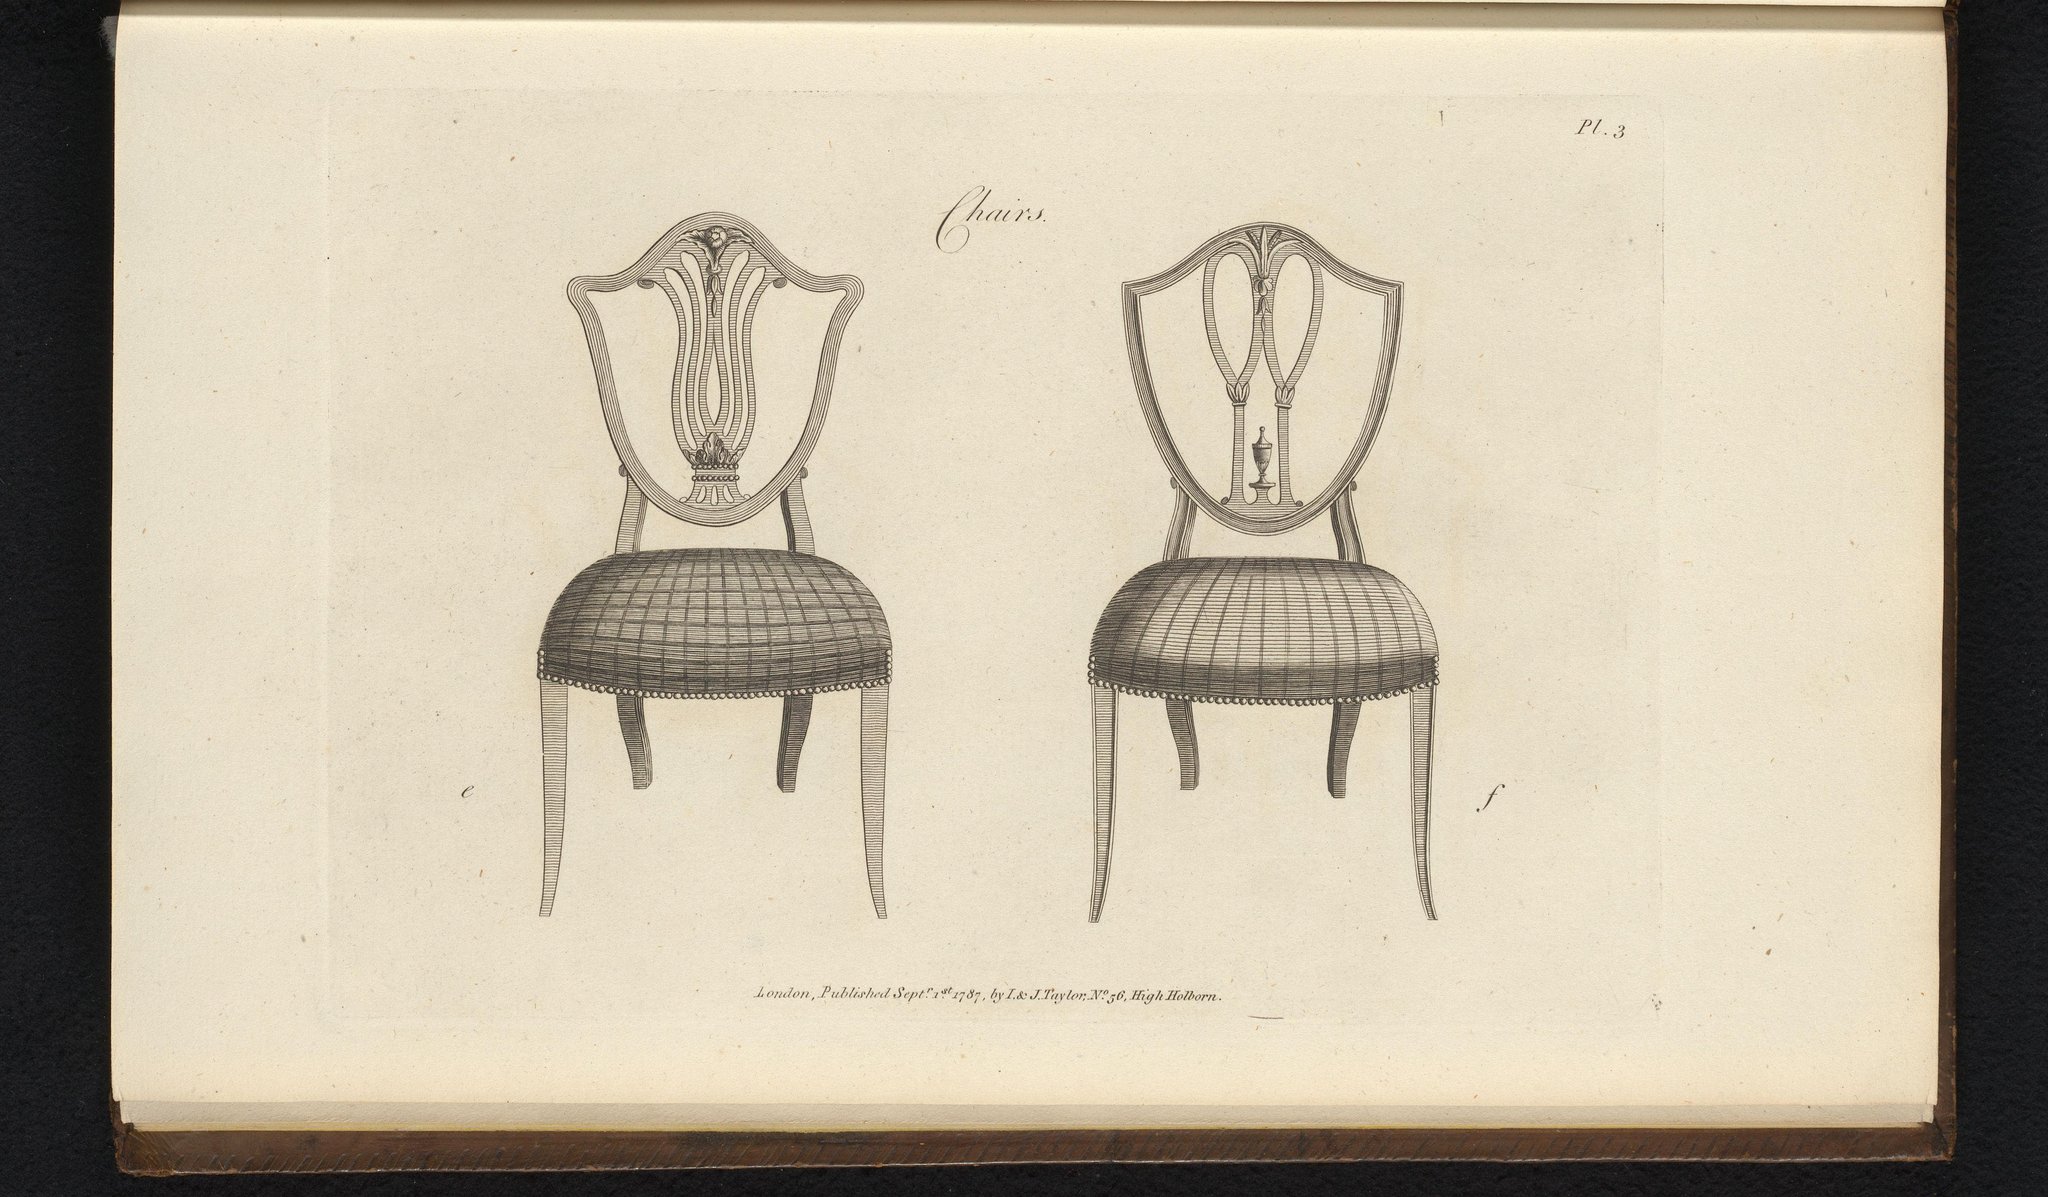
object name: print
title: Twee stoelen met verschillende ornamenten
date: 1787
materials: paper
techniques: engraving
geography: holborn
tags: chair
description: Genummerd: Pl. 3. Stoelen gemerkt: e en f. Prent maakt deel uit van een boek.